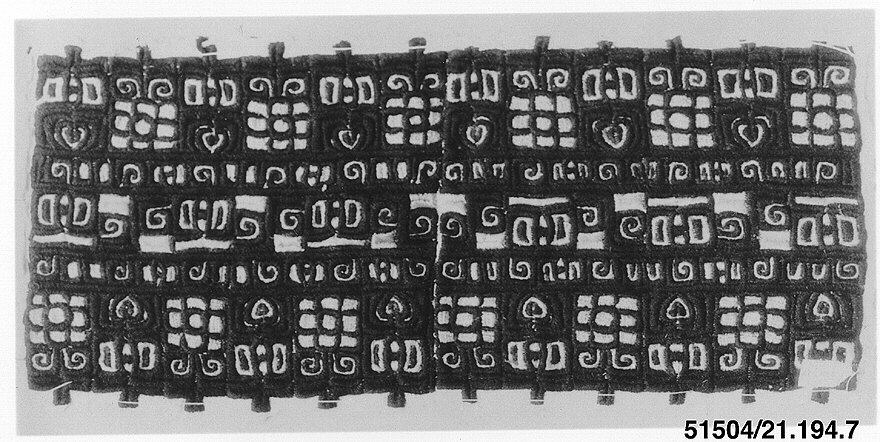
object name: strip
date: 1801-1900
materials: linen, wool